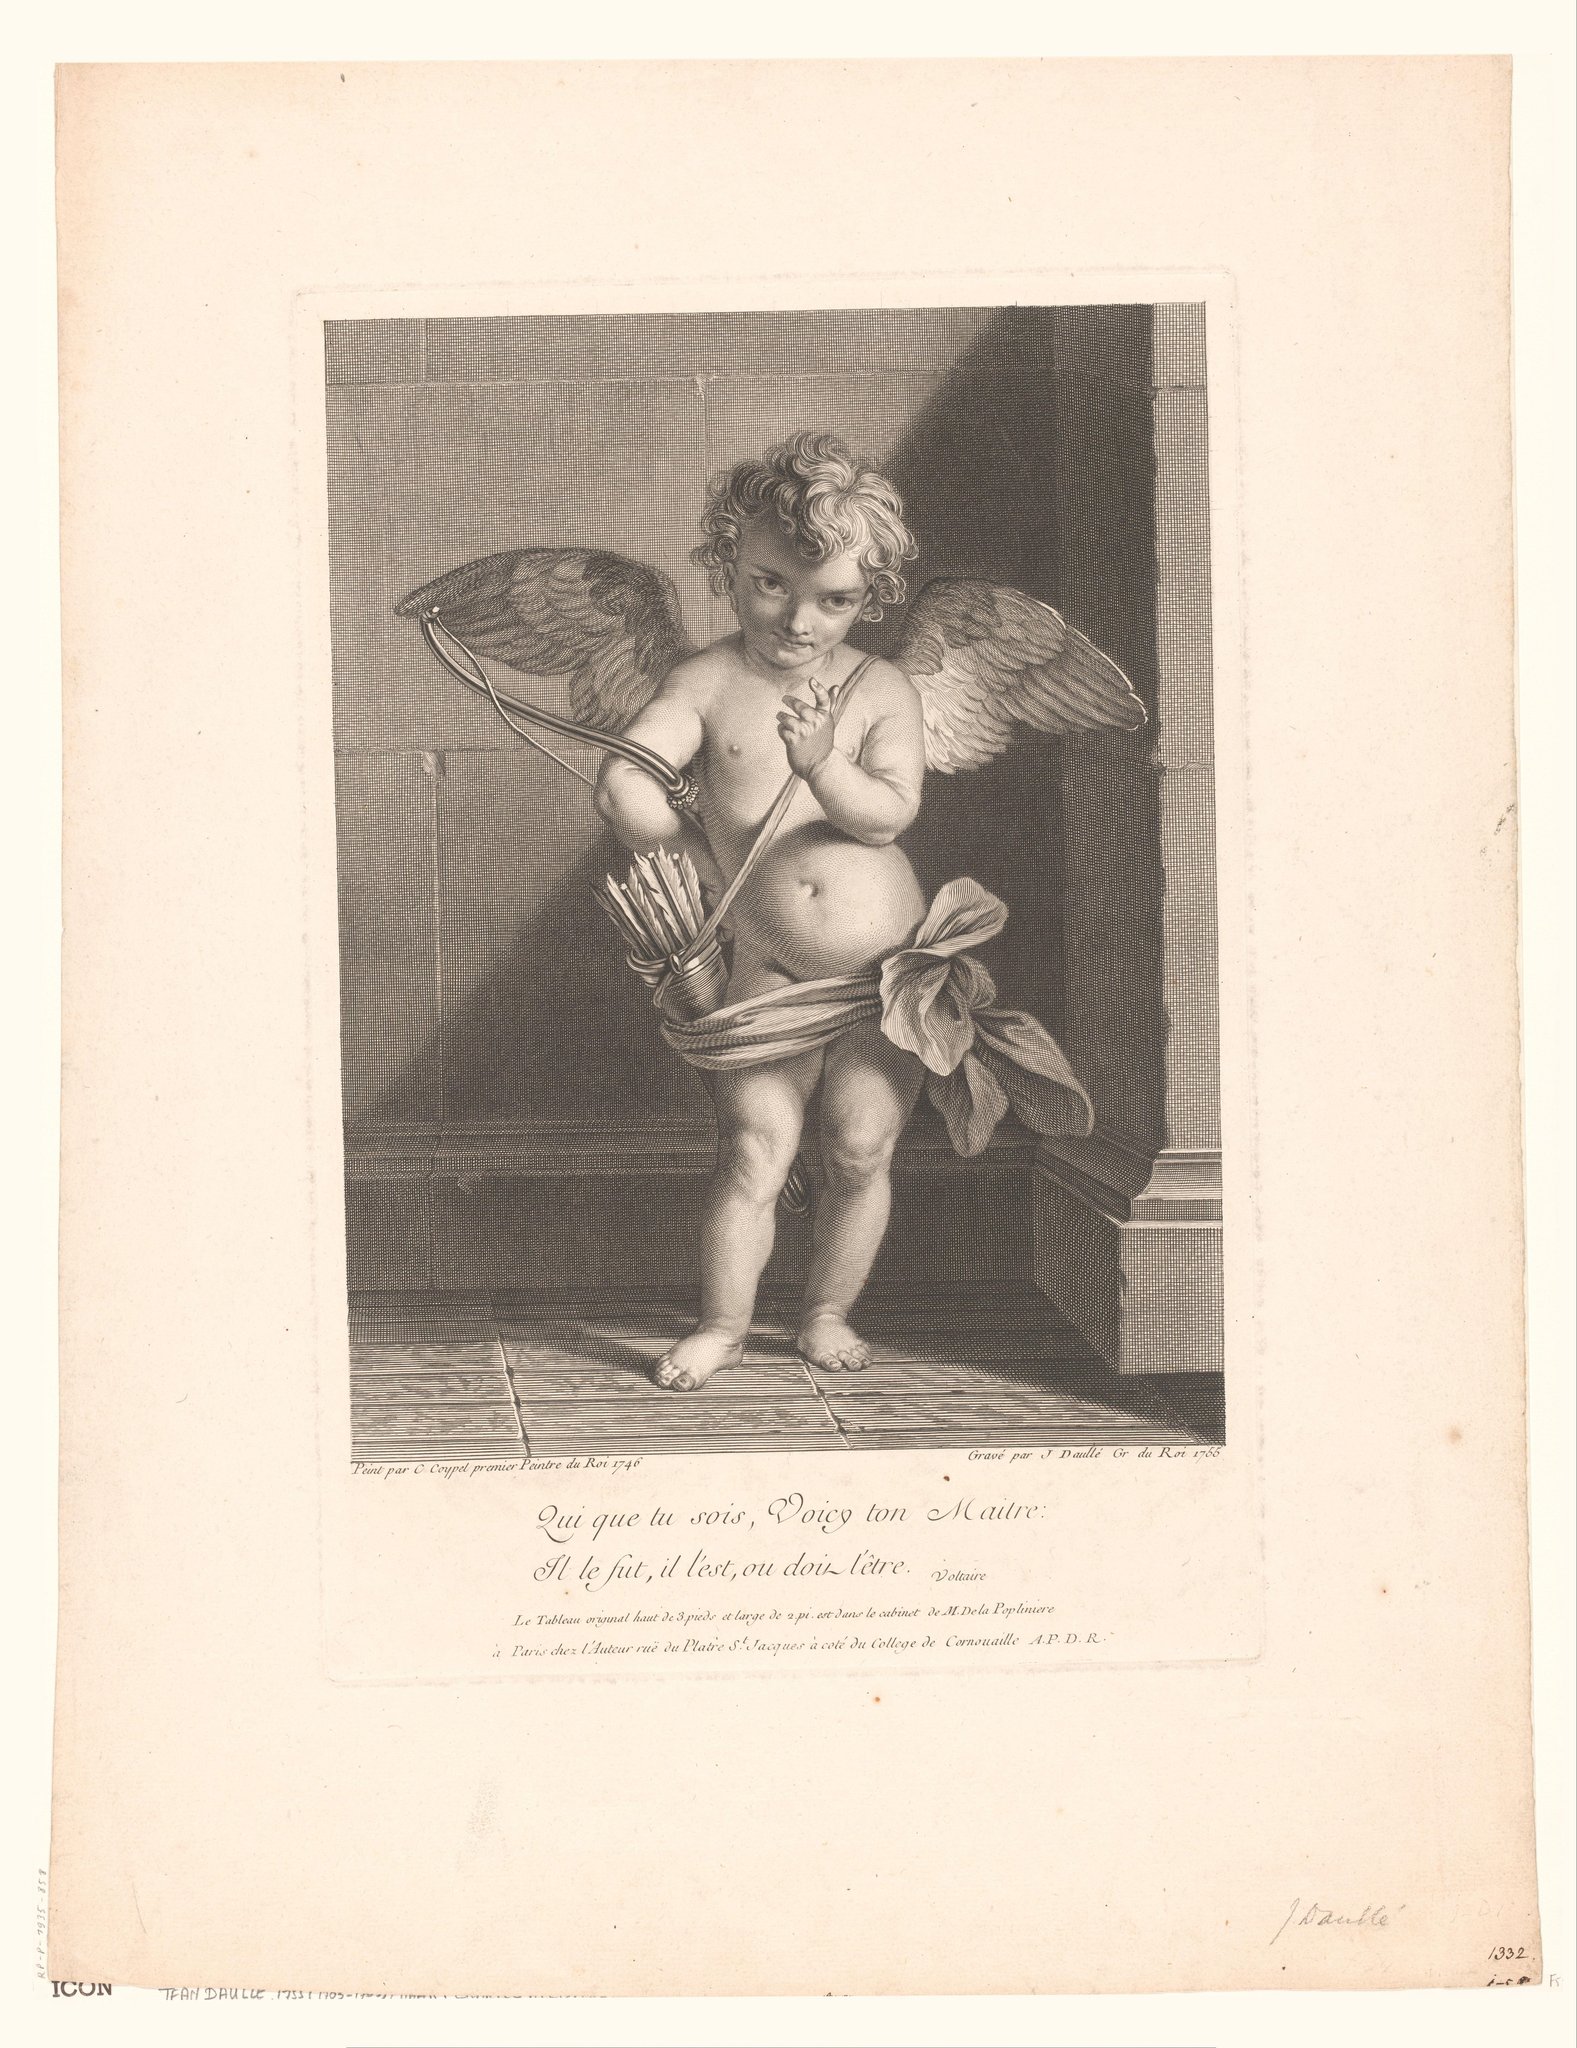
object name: print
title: Amor met pijl en boog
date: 1755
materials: paper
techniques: engraving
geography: france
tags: cupid handling his weapons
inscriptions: collector's mark: Lugt 2228